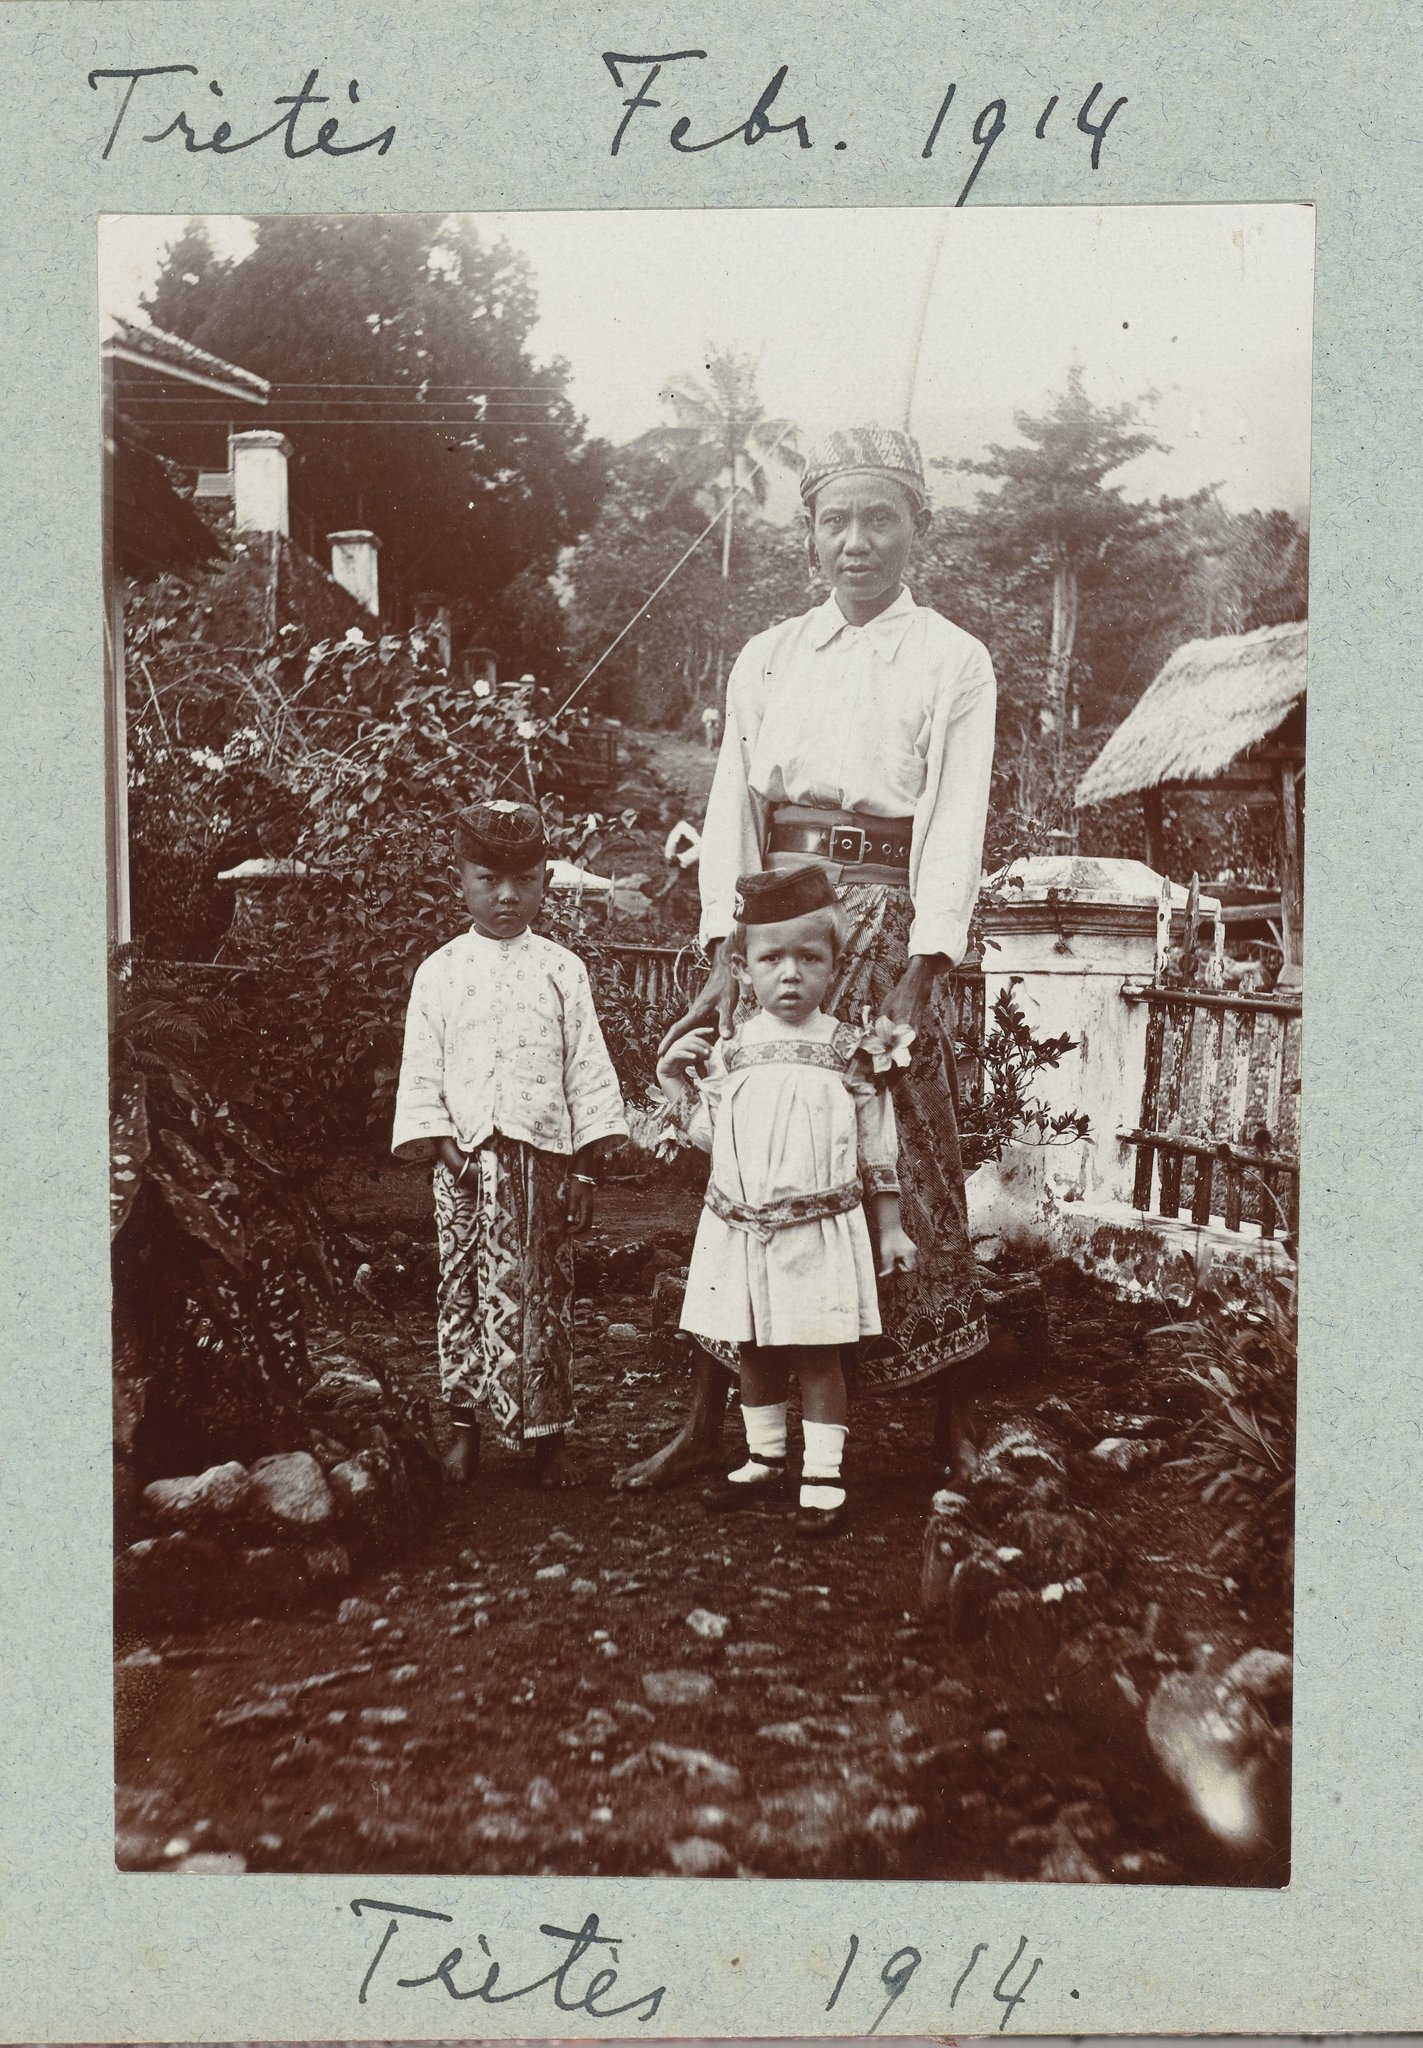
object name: photograph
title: Een man in balinese kleding met twee kinderen.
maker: frits freerks fontein fz.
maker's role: fotograaf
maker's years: 1882-1928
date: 1912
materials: cardboard, paper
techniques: gelatin silver print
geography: madura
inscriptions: caption: ‘1914. Tretes.’